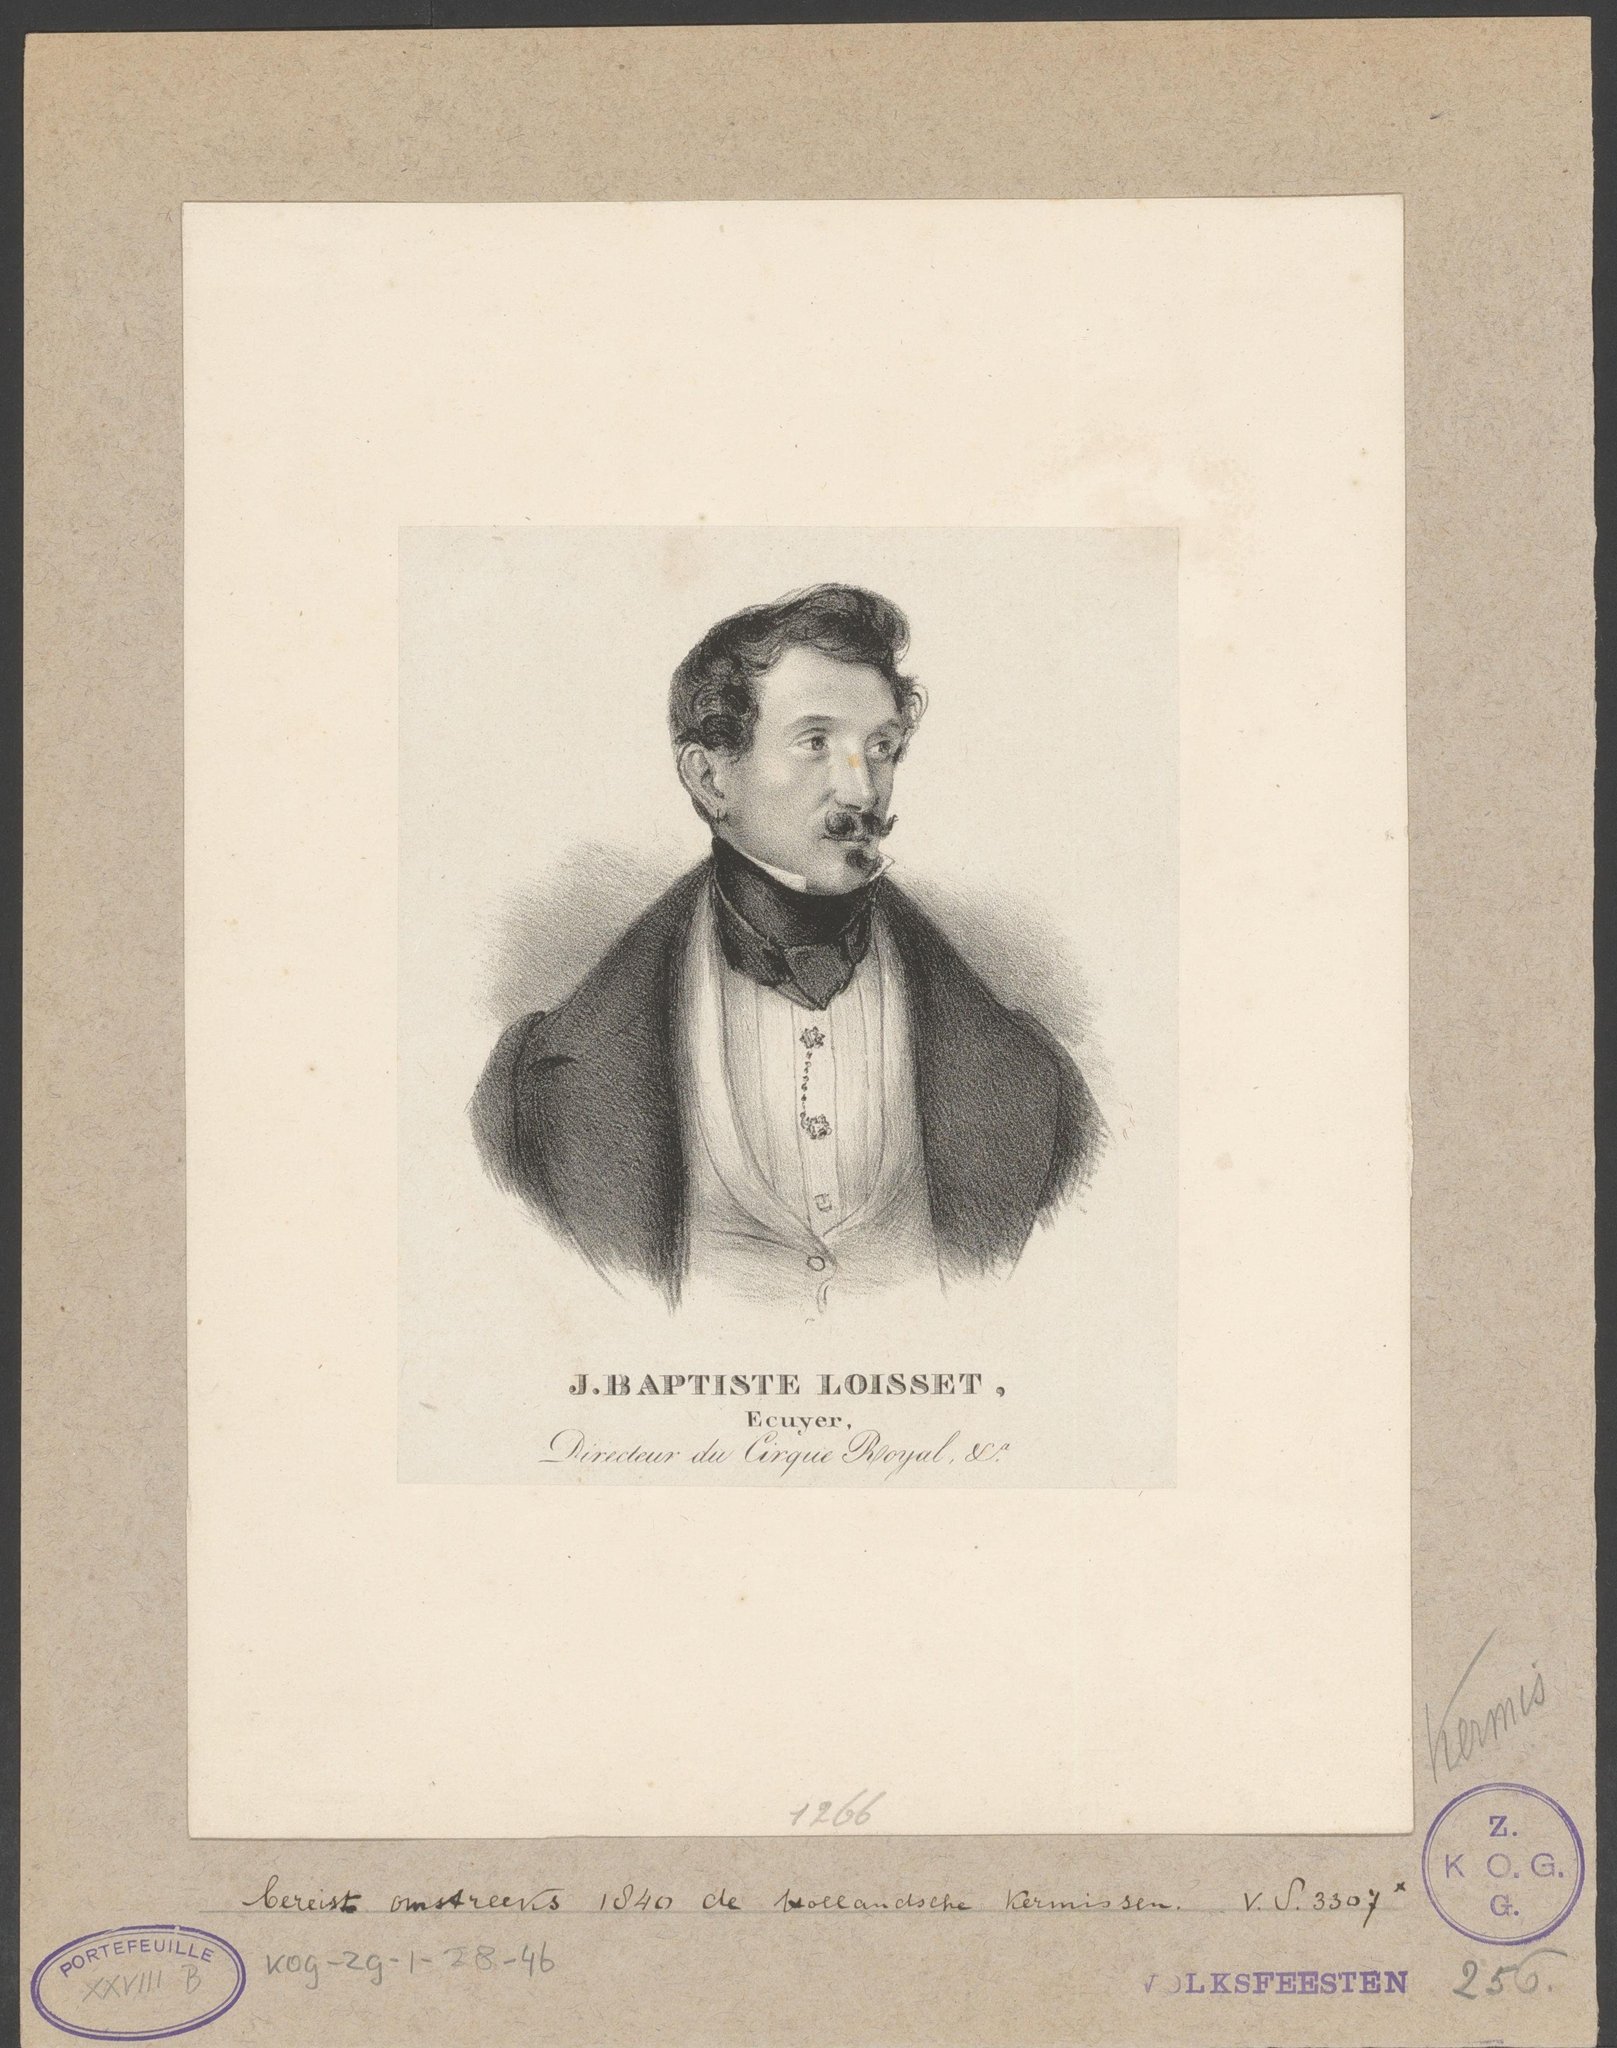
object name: print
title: Portret van Jean-Baptiste Loisset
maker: Anonymous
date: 1830-1840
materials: paper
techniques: lithograph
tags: historical persons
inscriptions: stamp, collector's mark: Lugt 1641, stamp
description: Portret van Jean-Baptiste Loisset, directeur van het Koninklijk Circus. Onderwerpsrubrieken binnen de Atlas Zeden en Gewoonten: Zeden en Gewoonten in Engeren Zin. Volksleven. Volksfeesten. Circusmenschen, dierentemmers, acrobaten, goochelaars, en dergelijken.